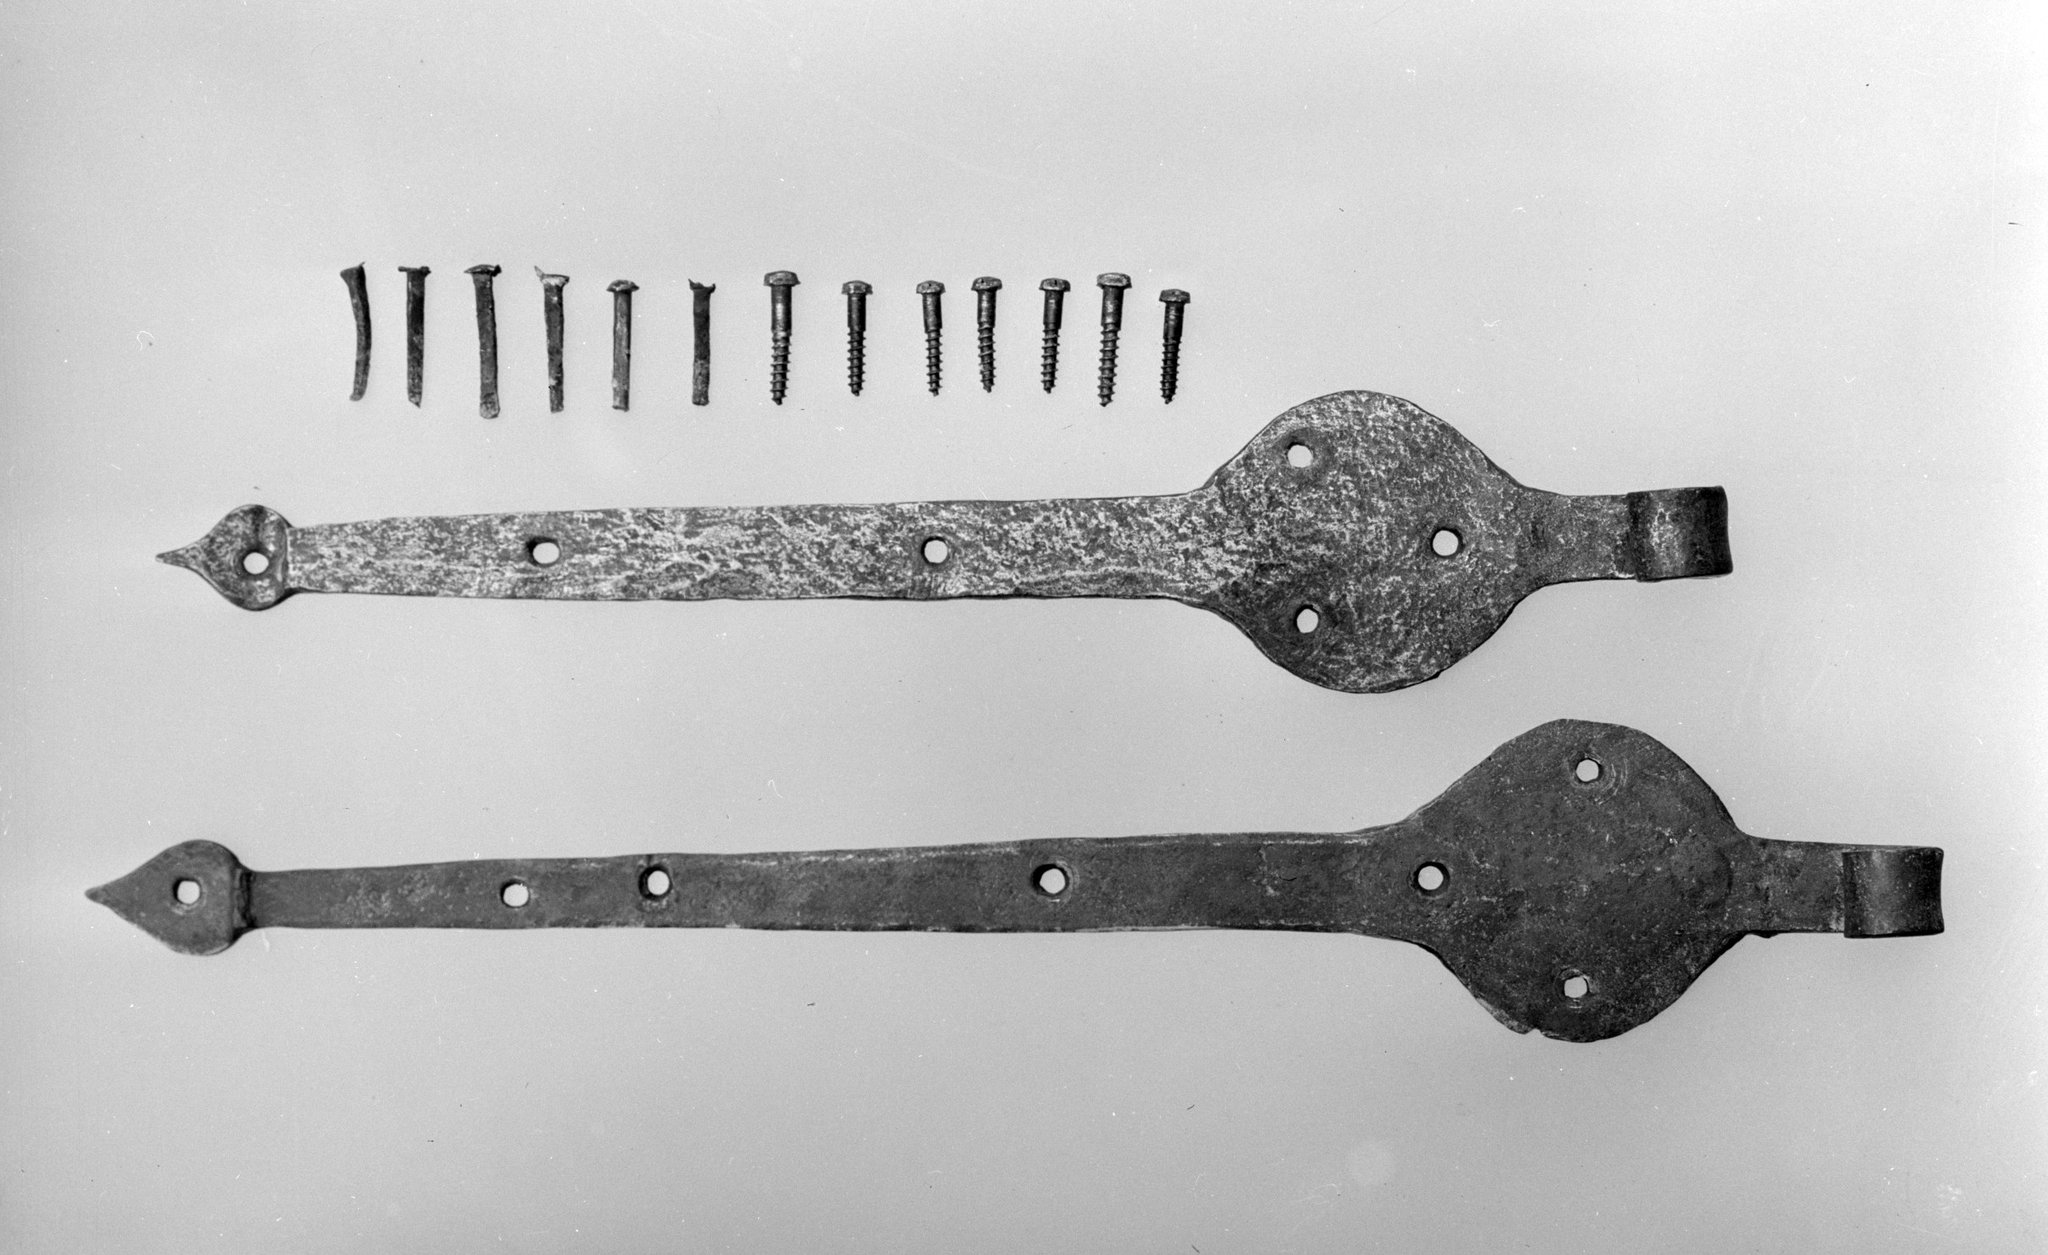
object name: hinge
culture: american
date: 1700-1800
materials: iron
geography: united states